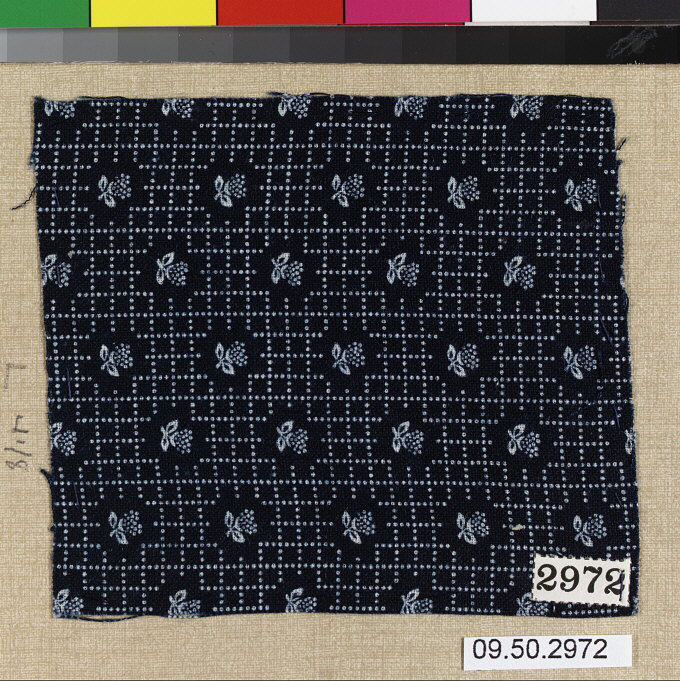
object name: piece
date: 1801-1900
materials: cotton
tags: flowers,leaves